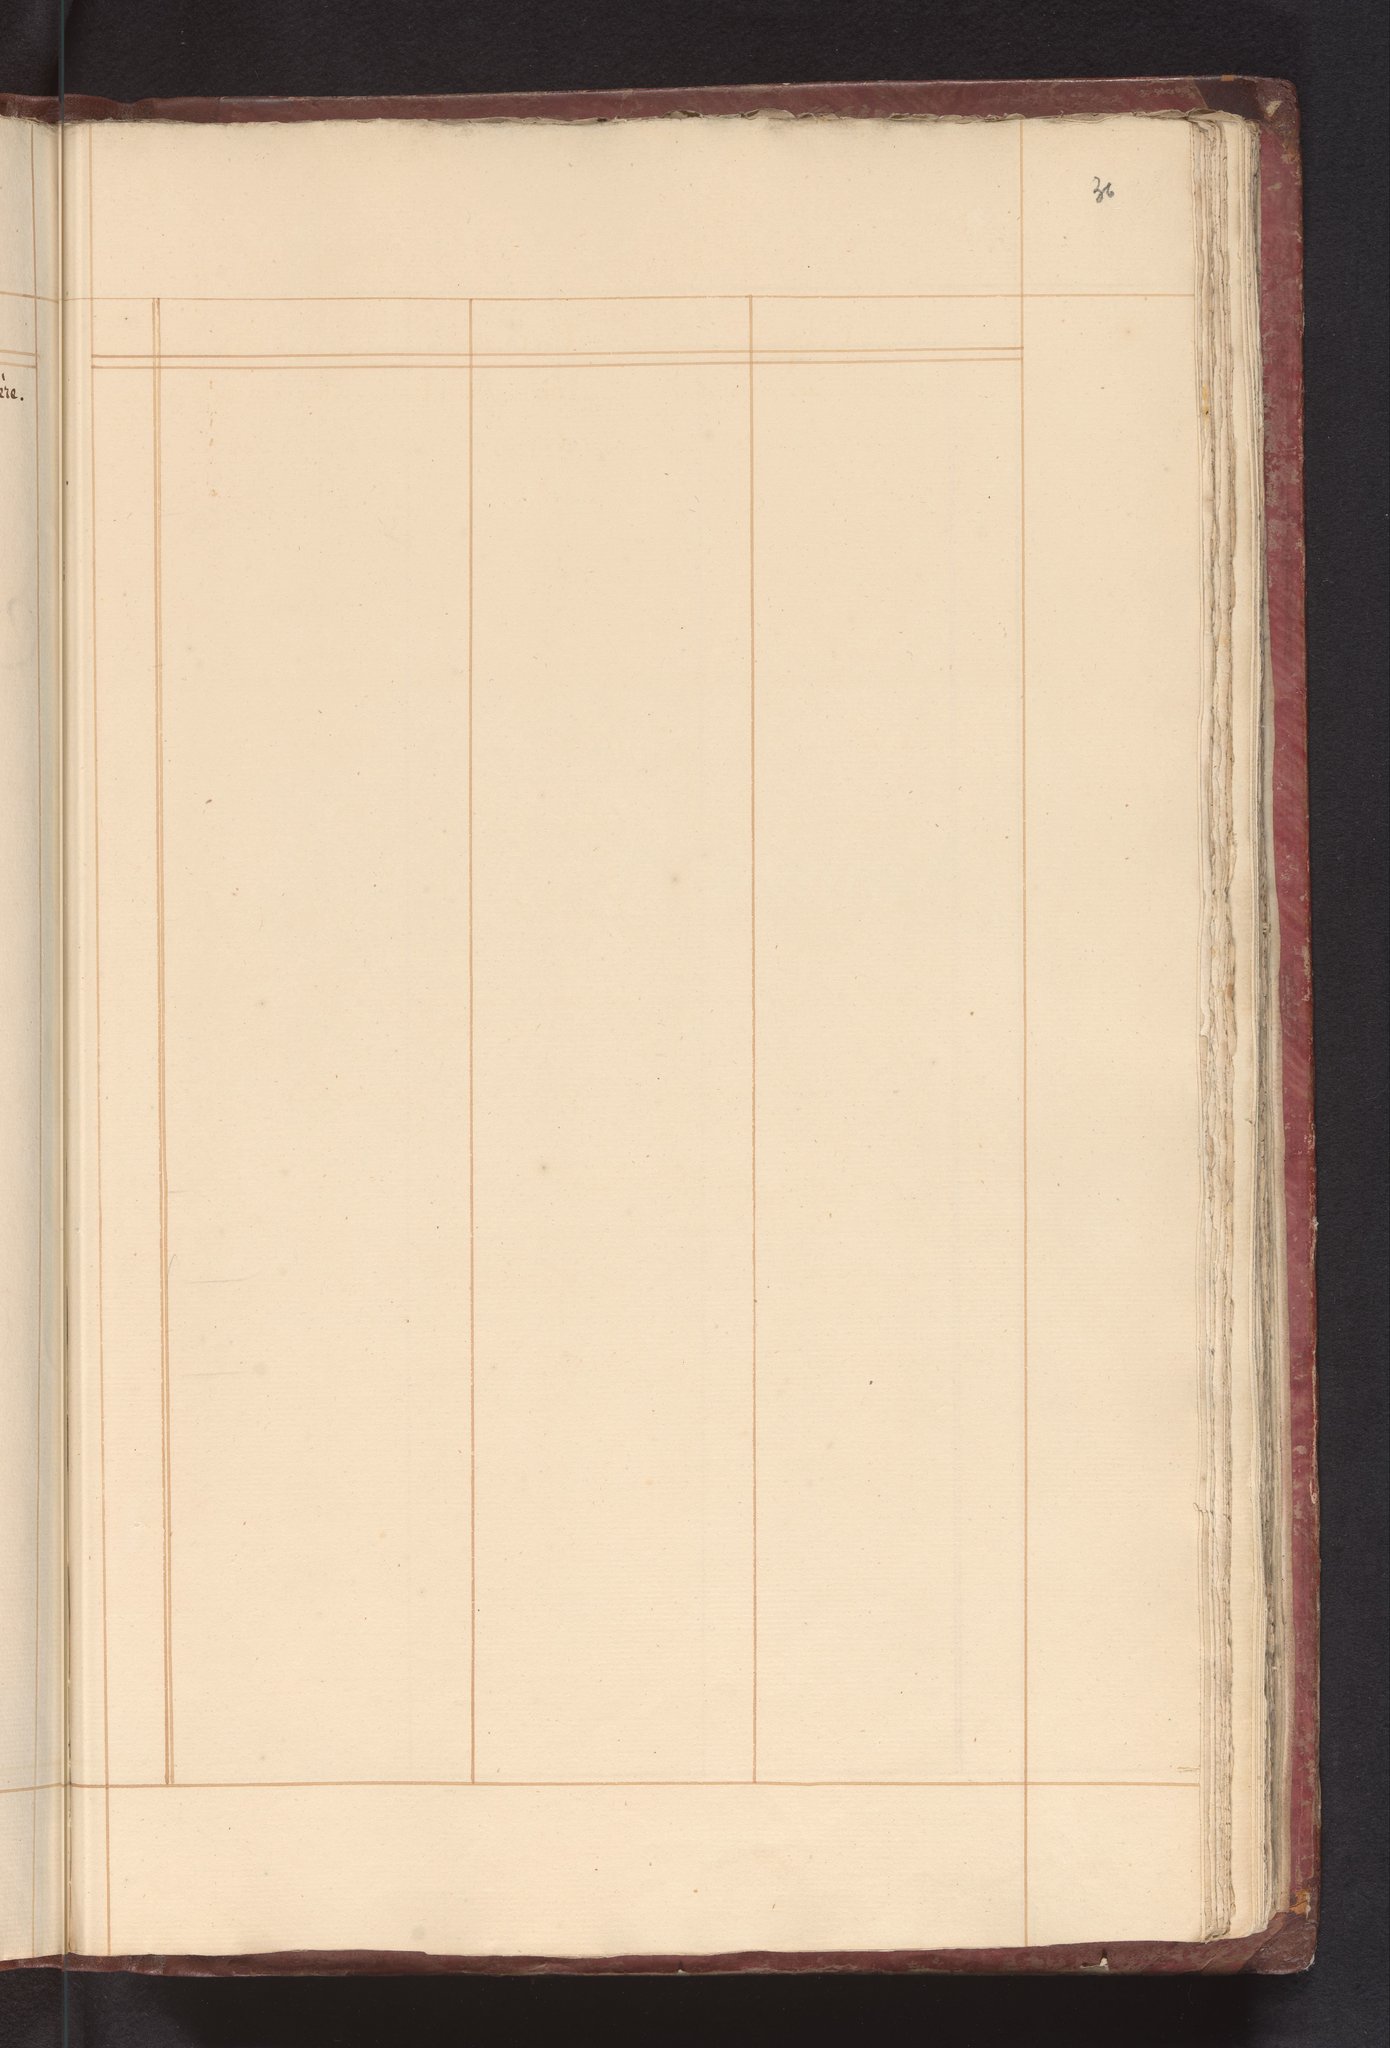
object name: manuscript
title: Oningevuld schema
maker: joseph van huerne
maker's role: kunstliefhebber, mecenas, verzamelaar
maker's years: 1752-1844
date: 1809-1814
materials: ink, paper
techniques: pen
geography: bruges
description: Oningevuld schema met drie kolommen. Onderdeel van het zesde album met tekeningen van vissen, schelpen en insekten. Zesde van twaalf albums met tekeningen van dieren, vogels en planten bekend rond 1600, gemaakt in opdracht van keizer Rudolf II. Met toelichting in Nederlands, Latijn en Frans.